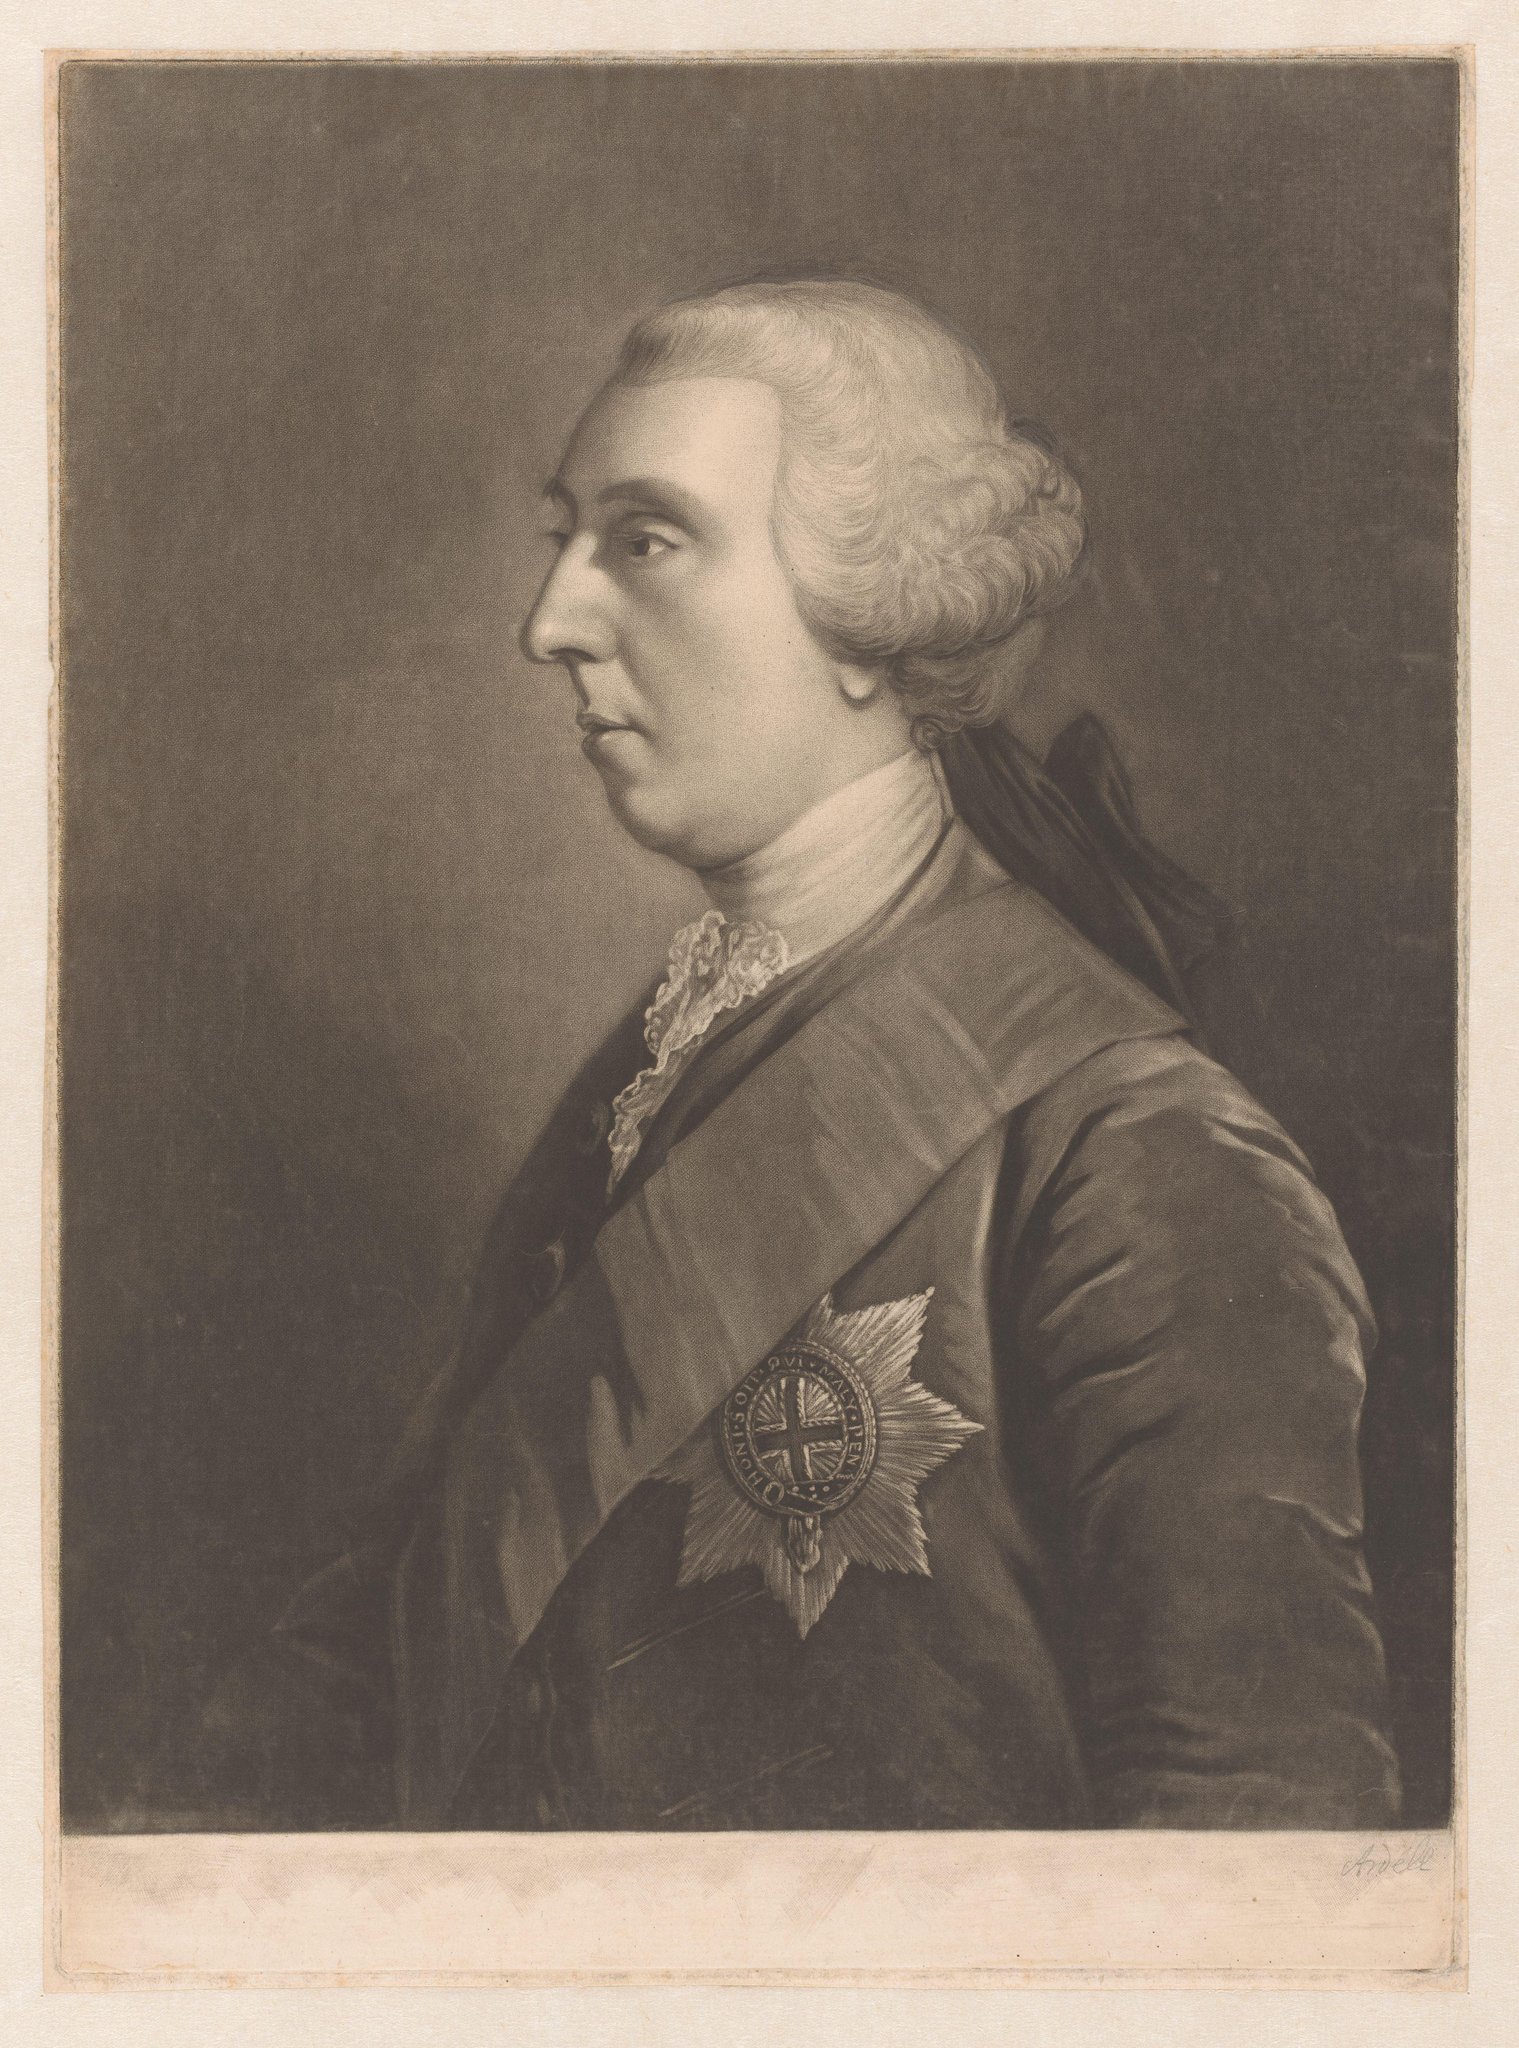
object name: print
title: Portret van James Waldegrave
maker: james mcardell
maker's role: print maker, publisher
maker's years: 1728-1765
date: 1762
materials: paper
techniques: mezzotint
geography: london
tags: politician, historical persons, politician, e.g. party leader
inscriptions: collector's mark: Lugt 240